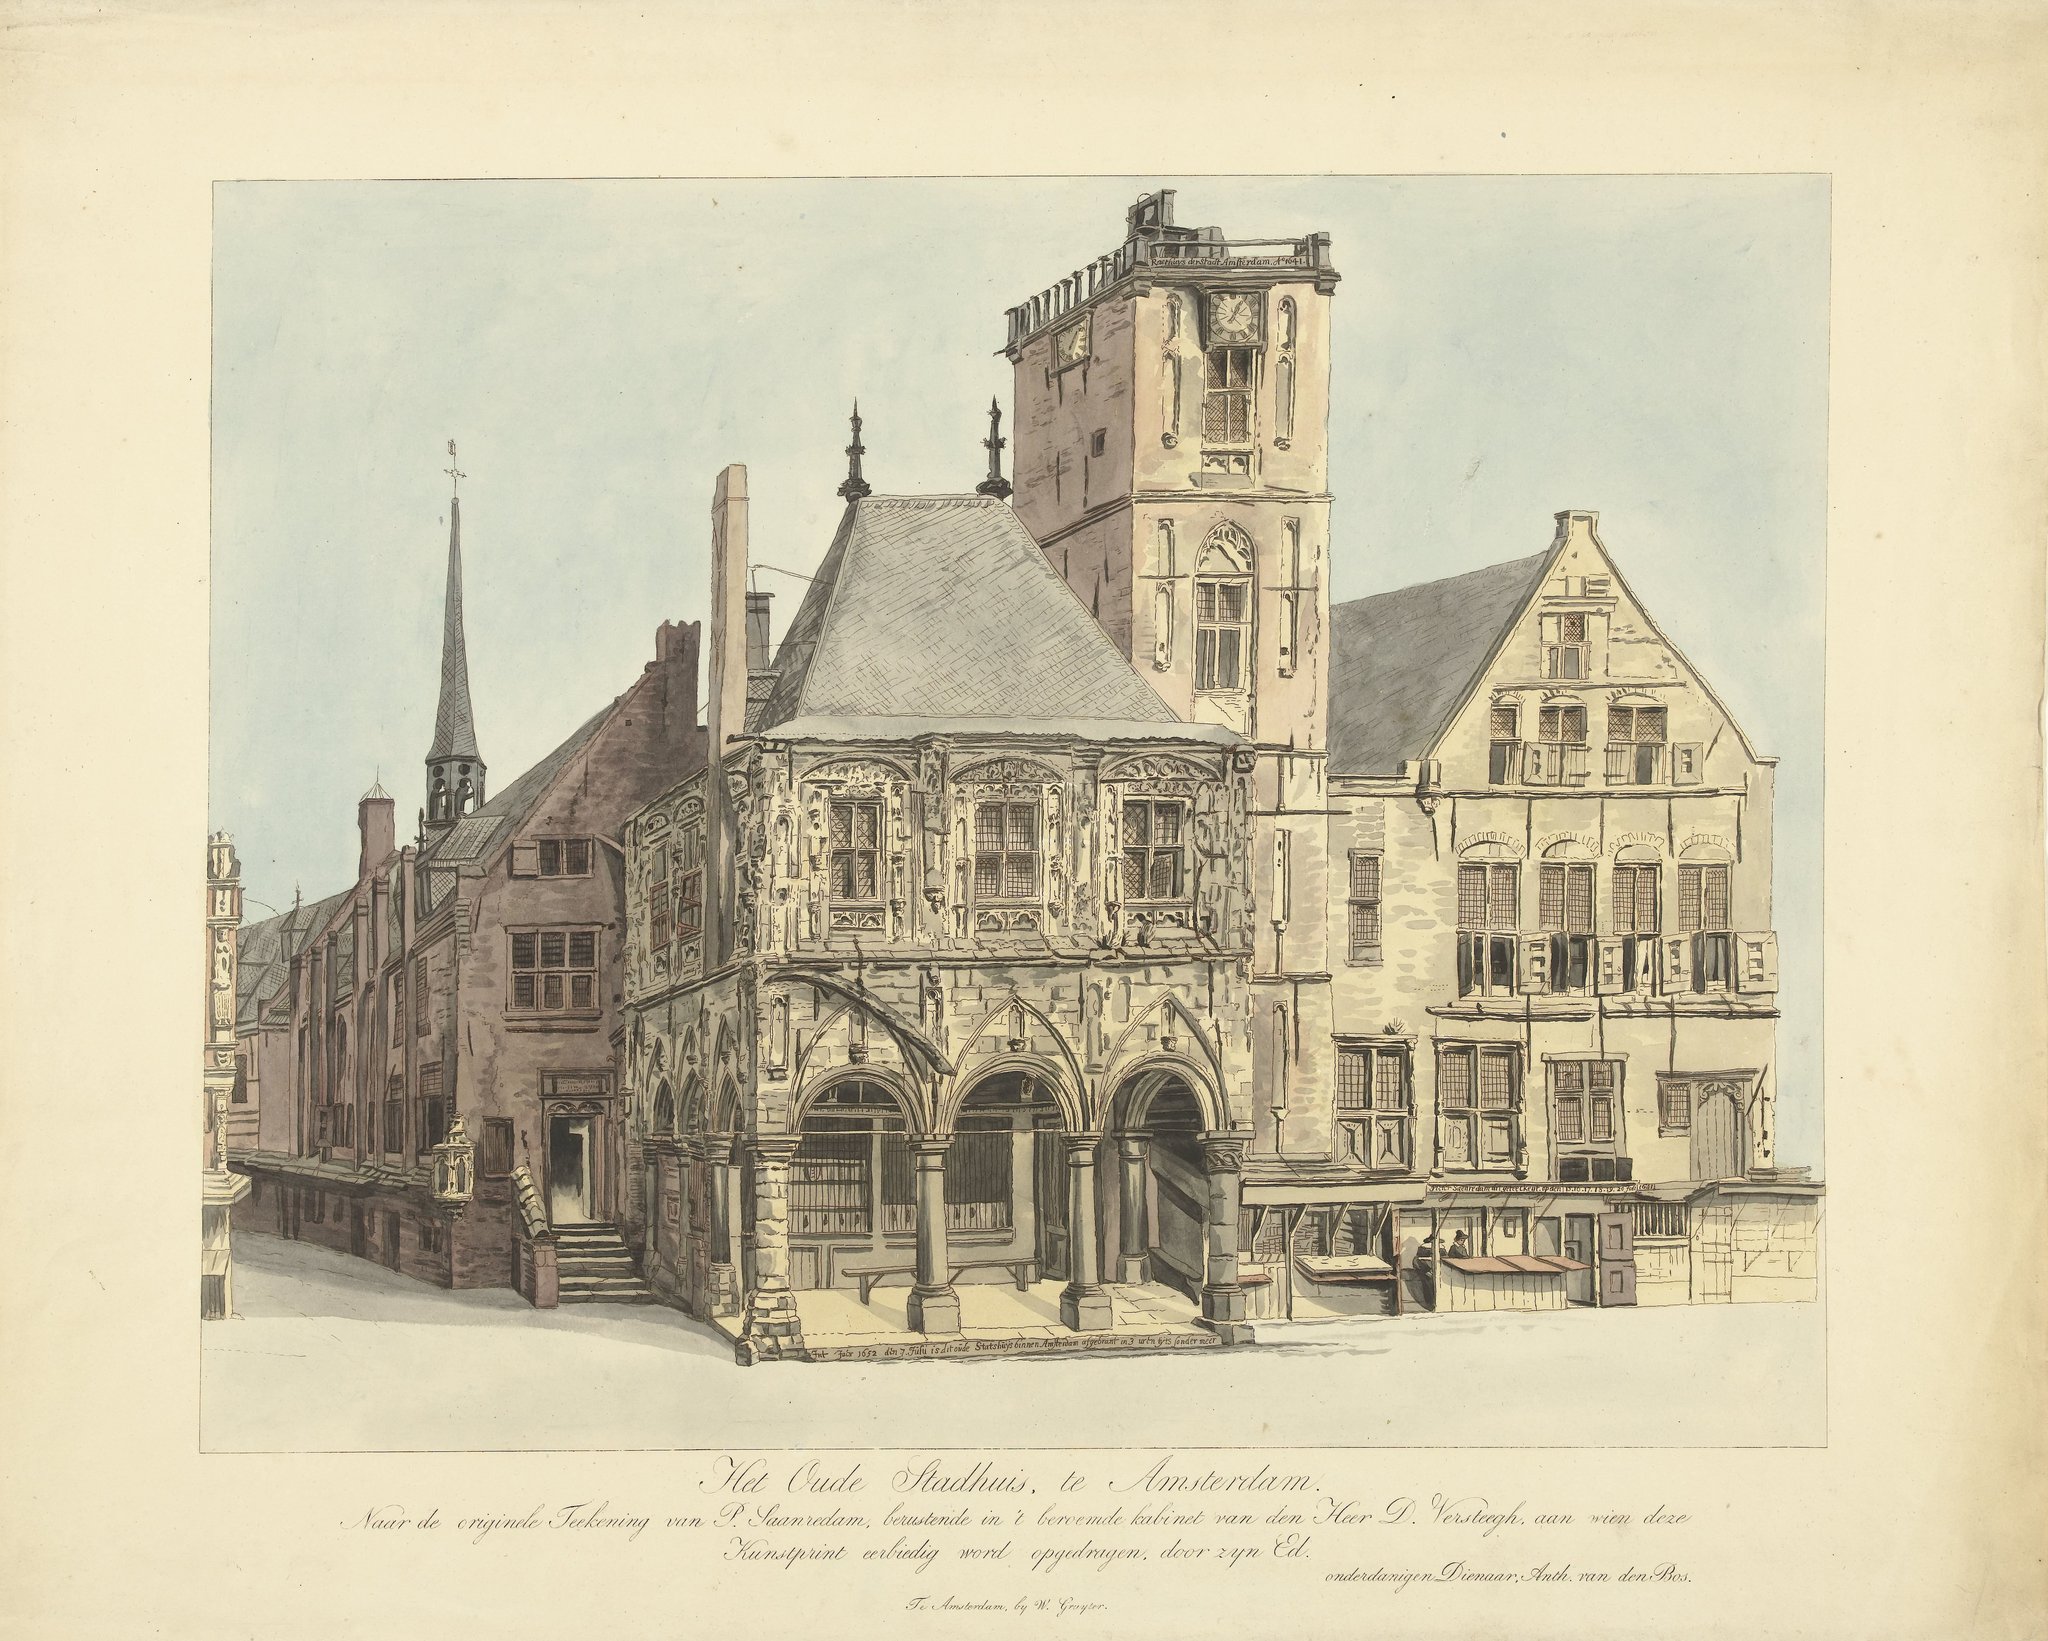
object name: print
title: Het Oude Stadhuis van Amsterdam, 1641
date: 1778-1838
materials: paper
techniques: brush, etching, hand coloring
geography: netherlands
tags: stadhuis van amsterdam (14e eeuw-1652)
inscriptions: collector's mark: Lugt 2233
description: Het Oude Stadhuis van Amsterdam, naar de tekening van 20 juni 1641. Op de stenen van de drempel een inscriptie over het afbranden van het stadhuis op 7 juli 1652.